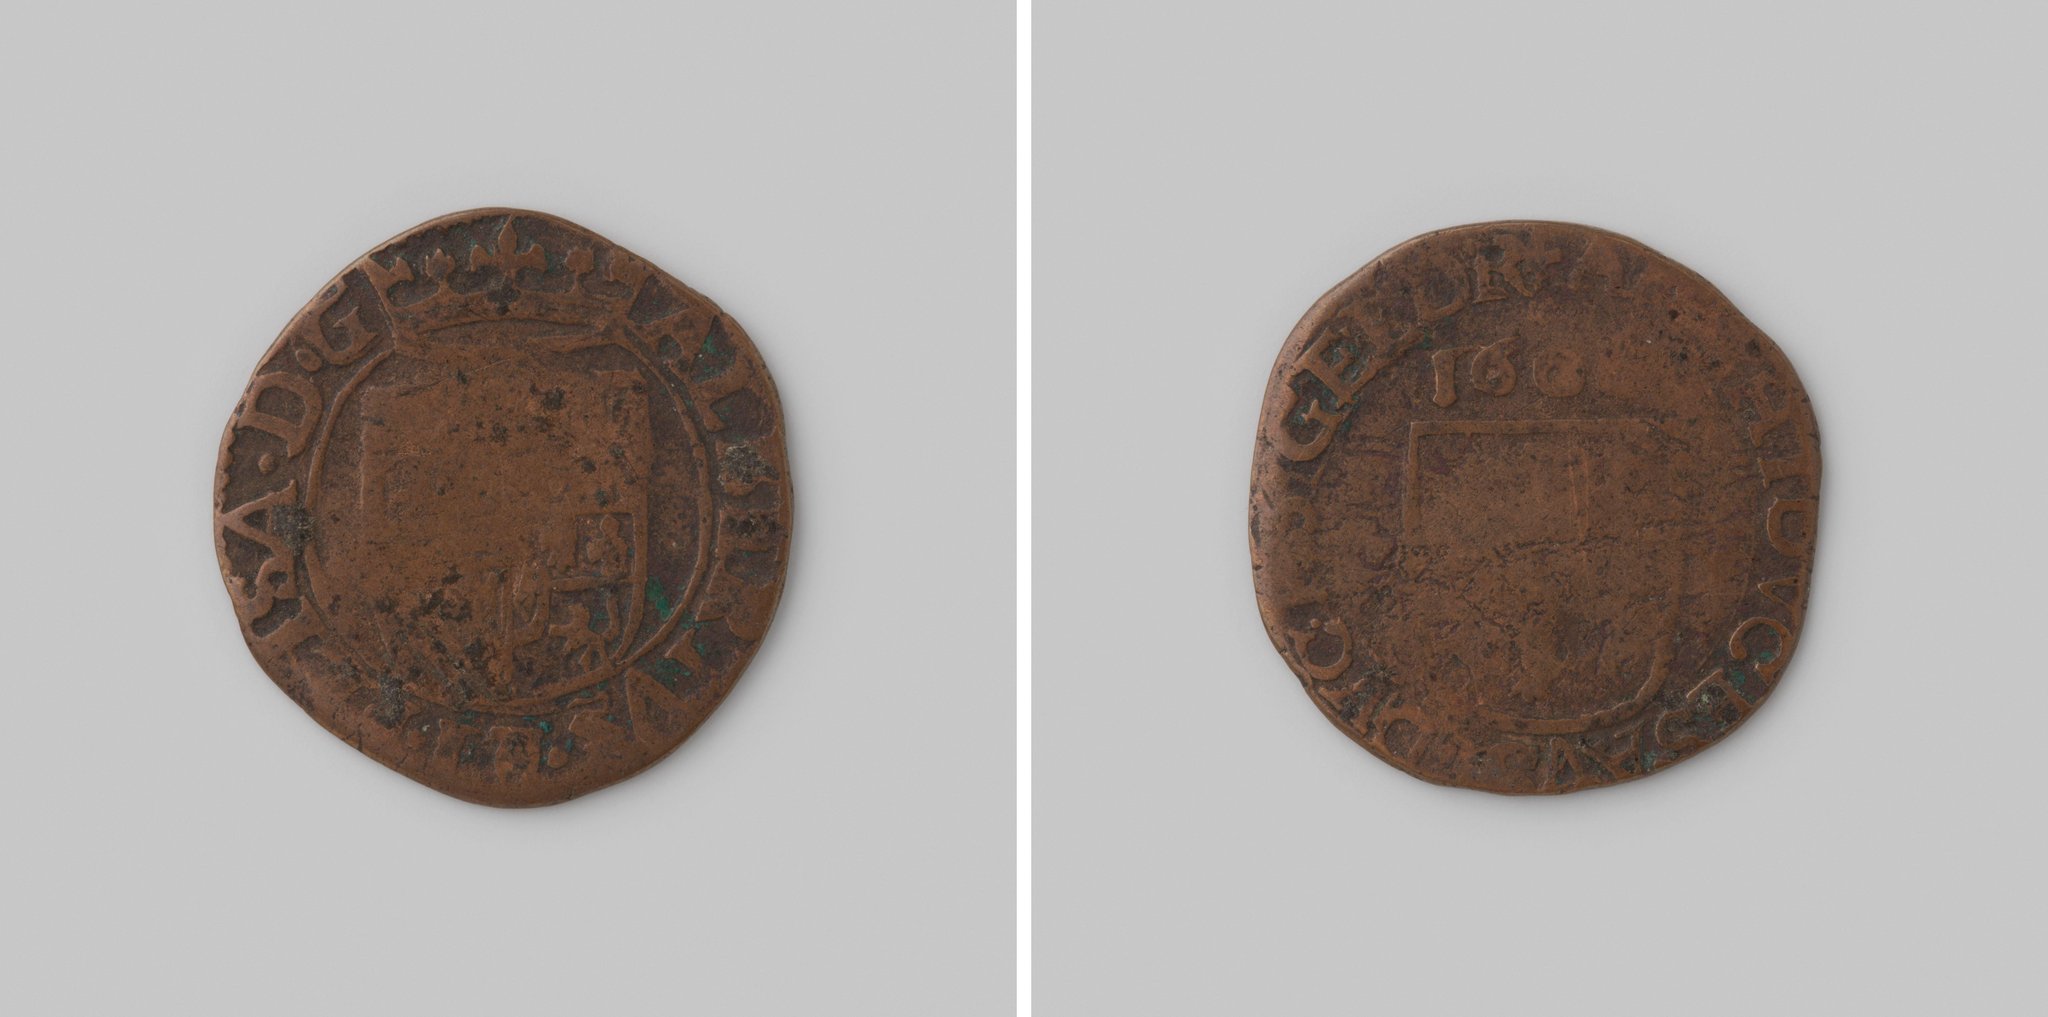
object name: coin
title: Roermond, duit, 1606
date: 1606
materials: copper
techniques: striking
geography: roermond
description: Voorzijde: gekroond wapenschild van de aartshertogen. Keerzijde: wapenschild van Roermond, waarboven jaartal.